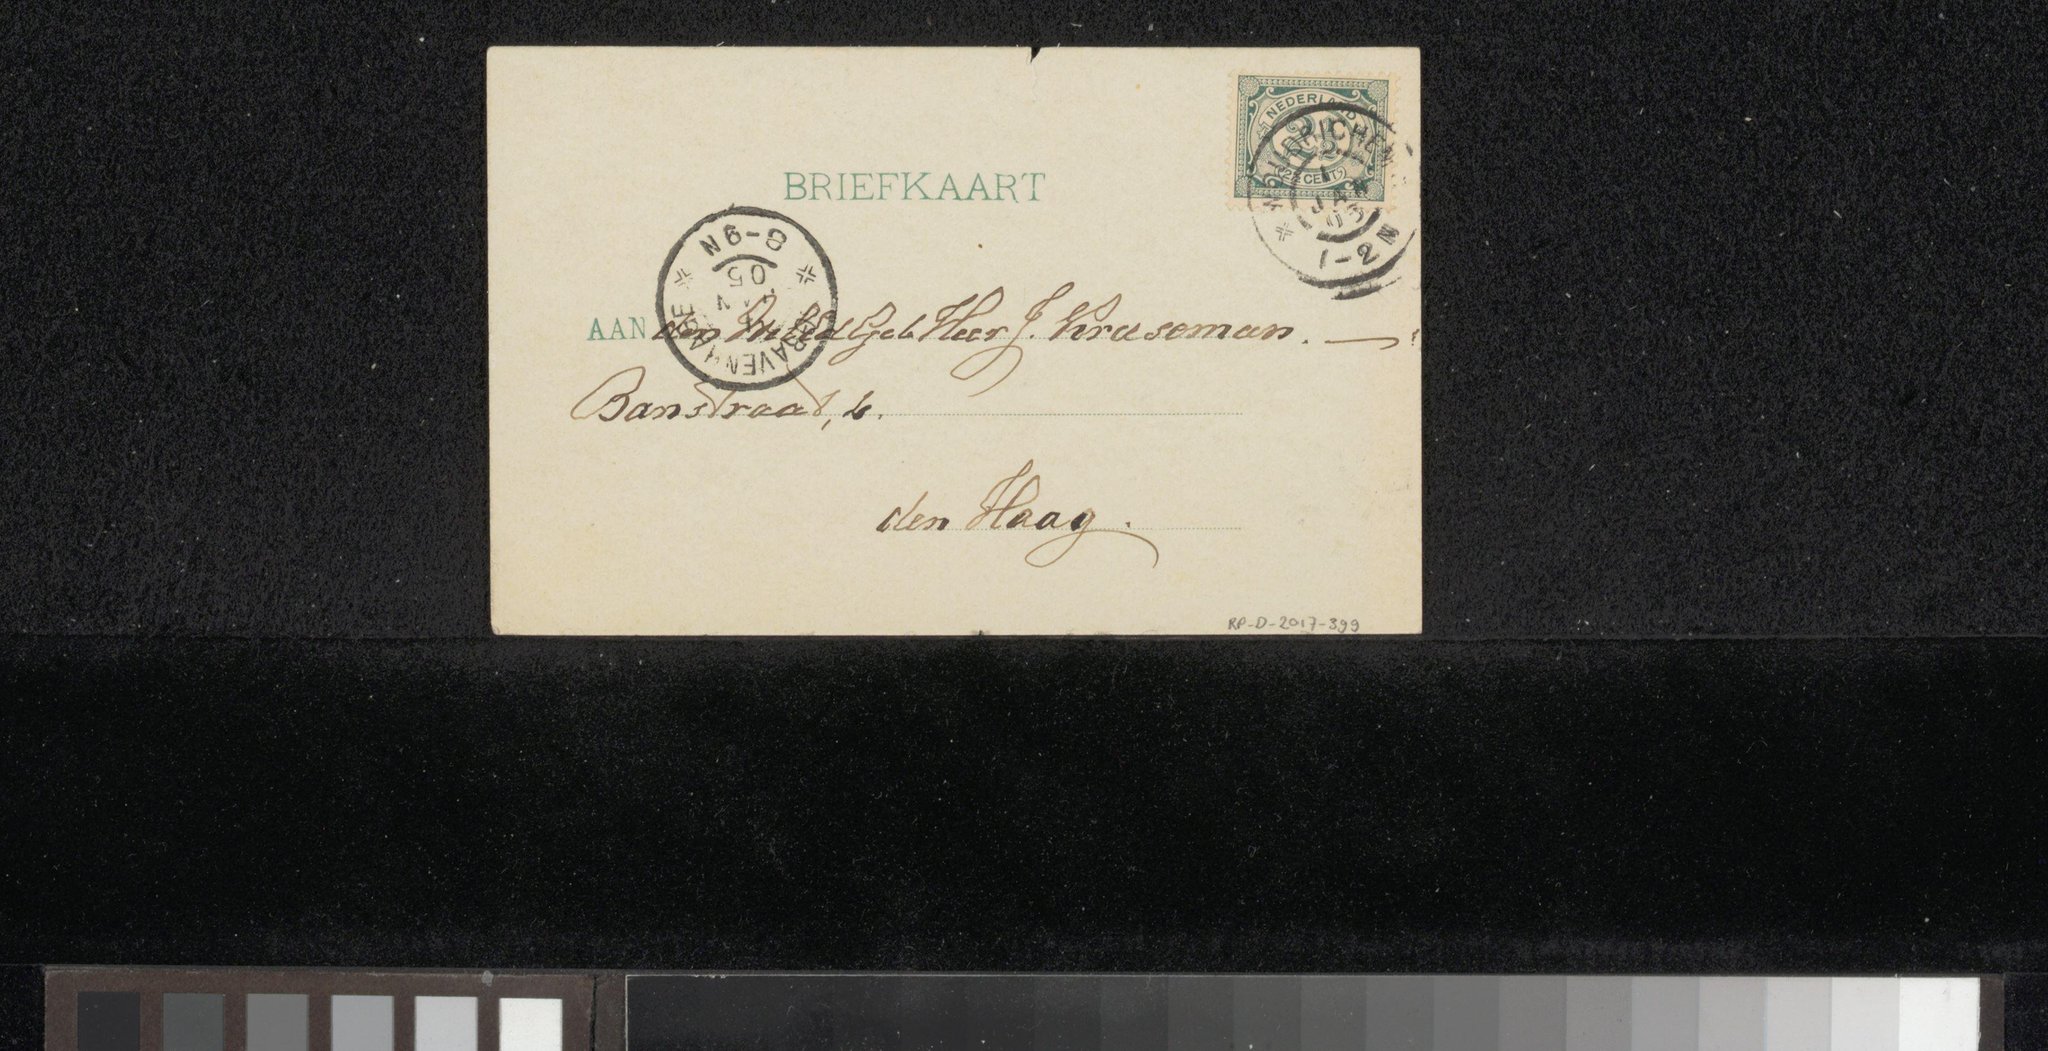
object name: postcard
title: Briefkaart aan Jan Diederikus Kruseman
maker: louwrens hanedoes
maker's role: painter, print maker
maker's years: 1822-1905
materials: cardboard, ink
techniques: pen, writing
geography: kraaiveld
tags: the hague, draughtsman, jan diederikus kruseman, diseases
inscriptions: collector's mark: Lugt 2233